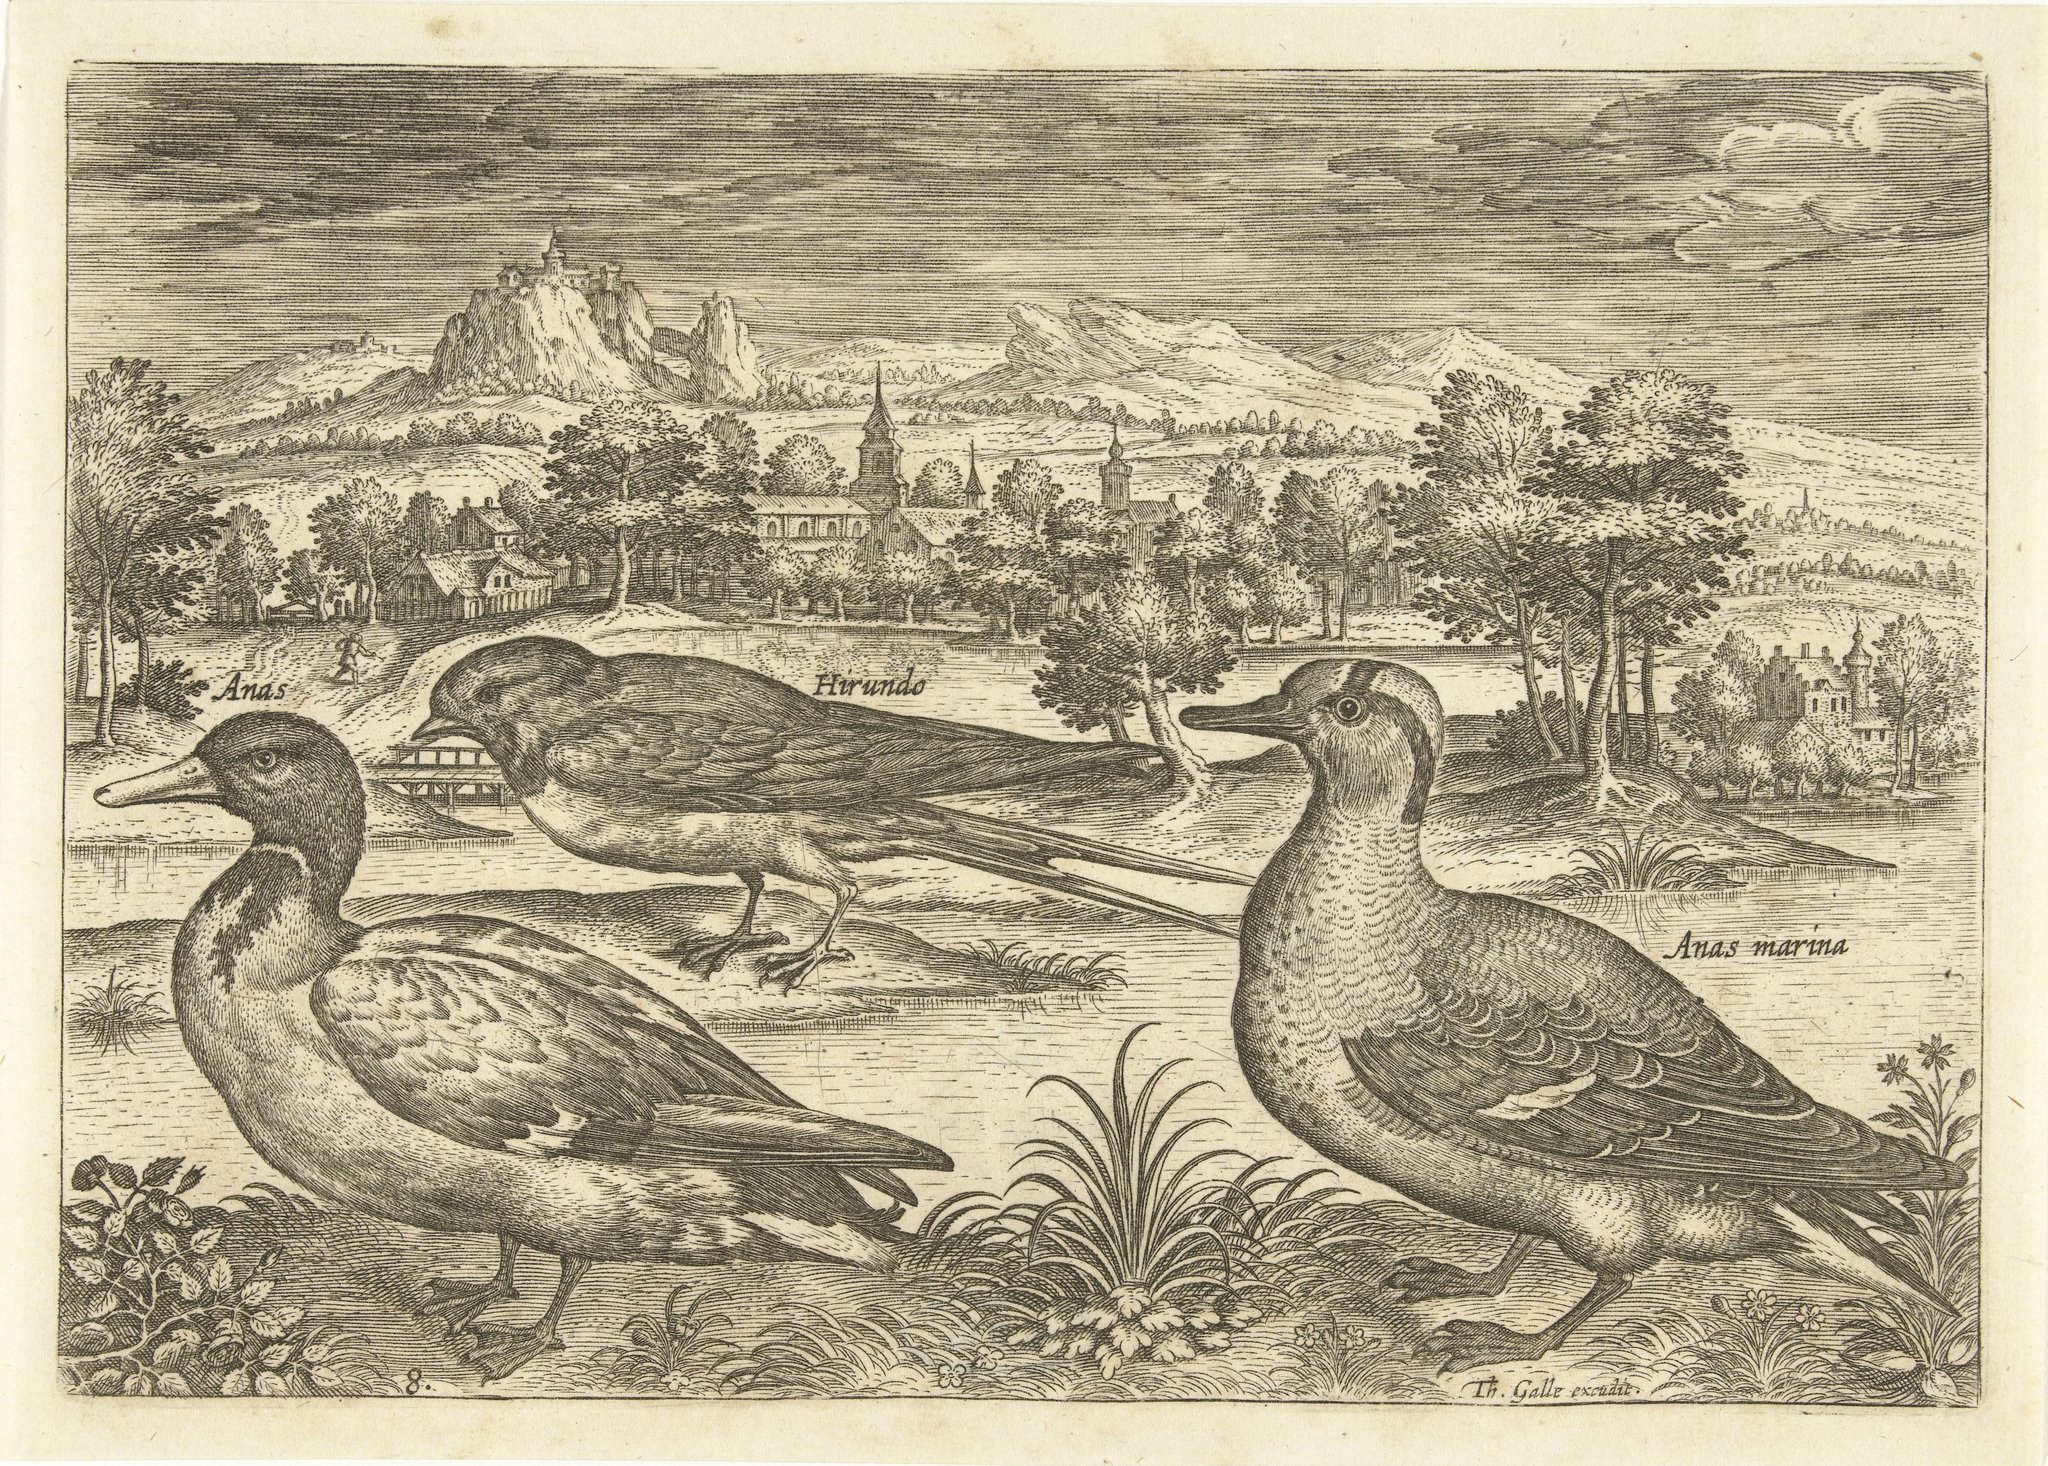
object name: print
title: Enkele vogels in een landschap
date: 1598-1618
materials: paper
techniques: engraving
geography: antwerp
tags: river, song-birds: swallow, water-birds: duck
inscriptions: collector's mark: Lugt 2228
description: Twee wilde eenden en een zwaluw in een rivierlandschap. Op de achtergrond een kerk. De prent maakt deel uit van een serie met vogels als onderwerp.